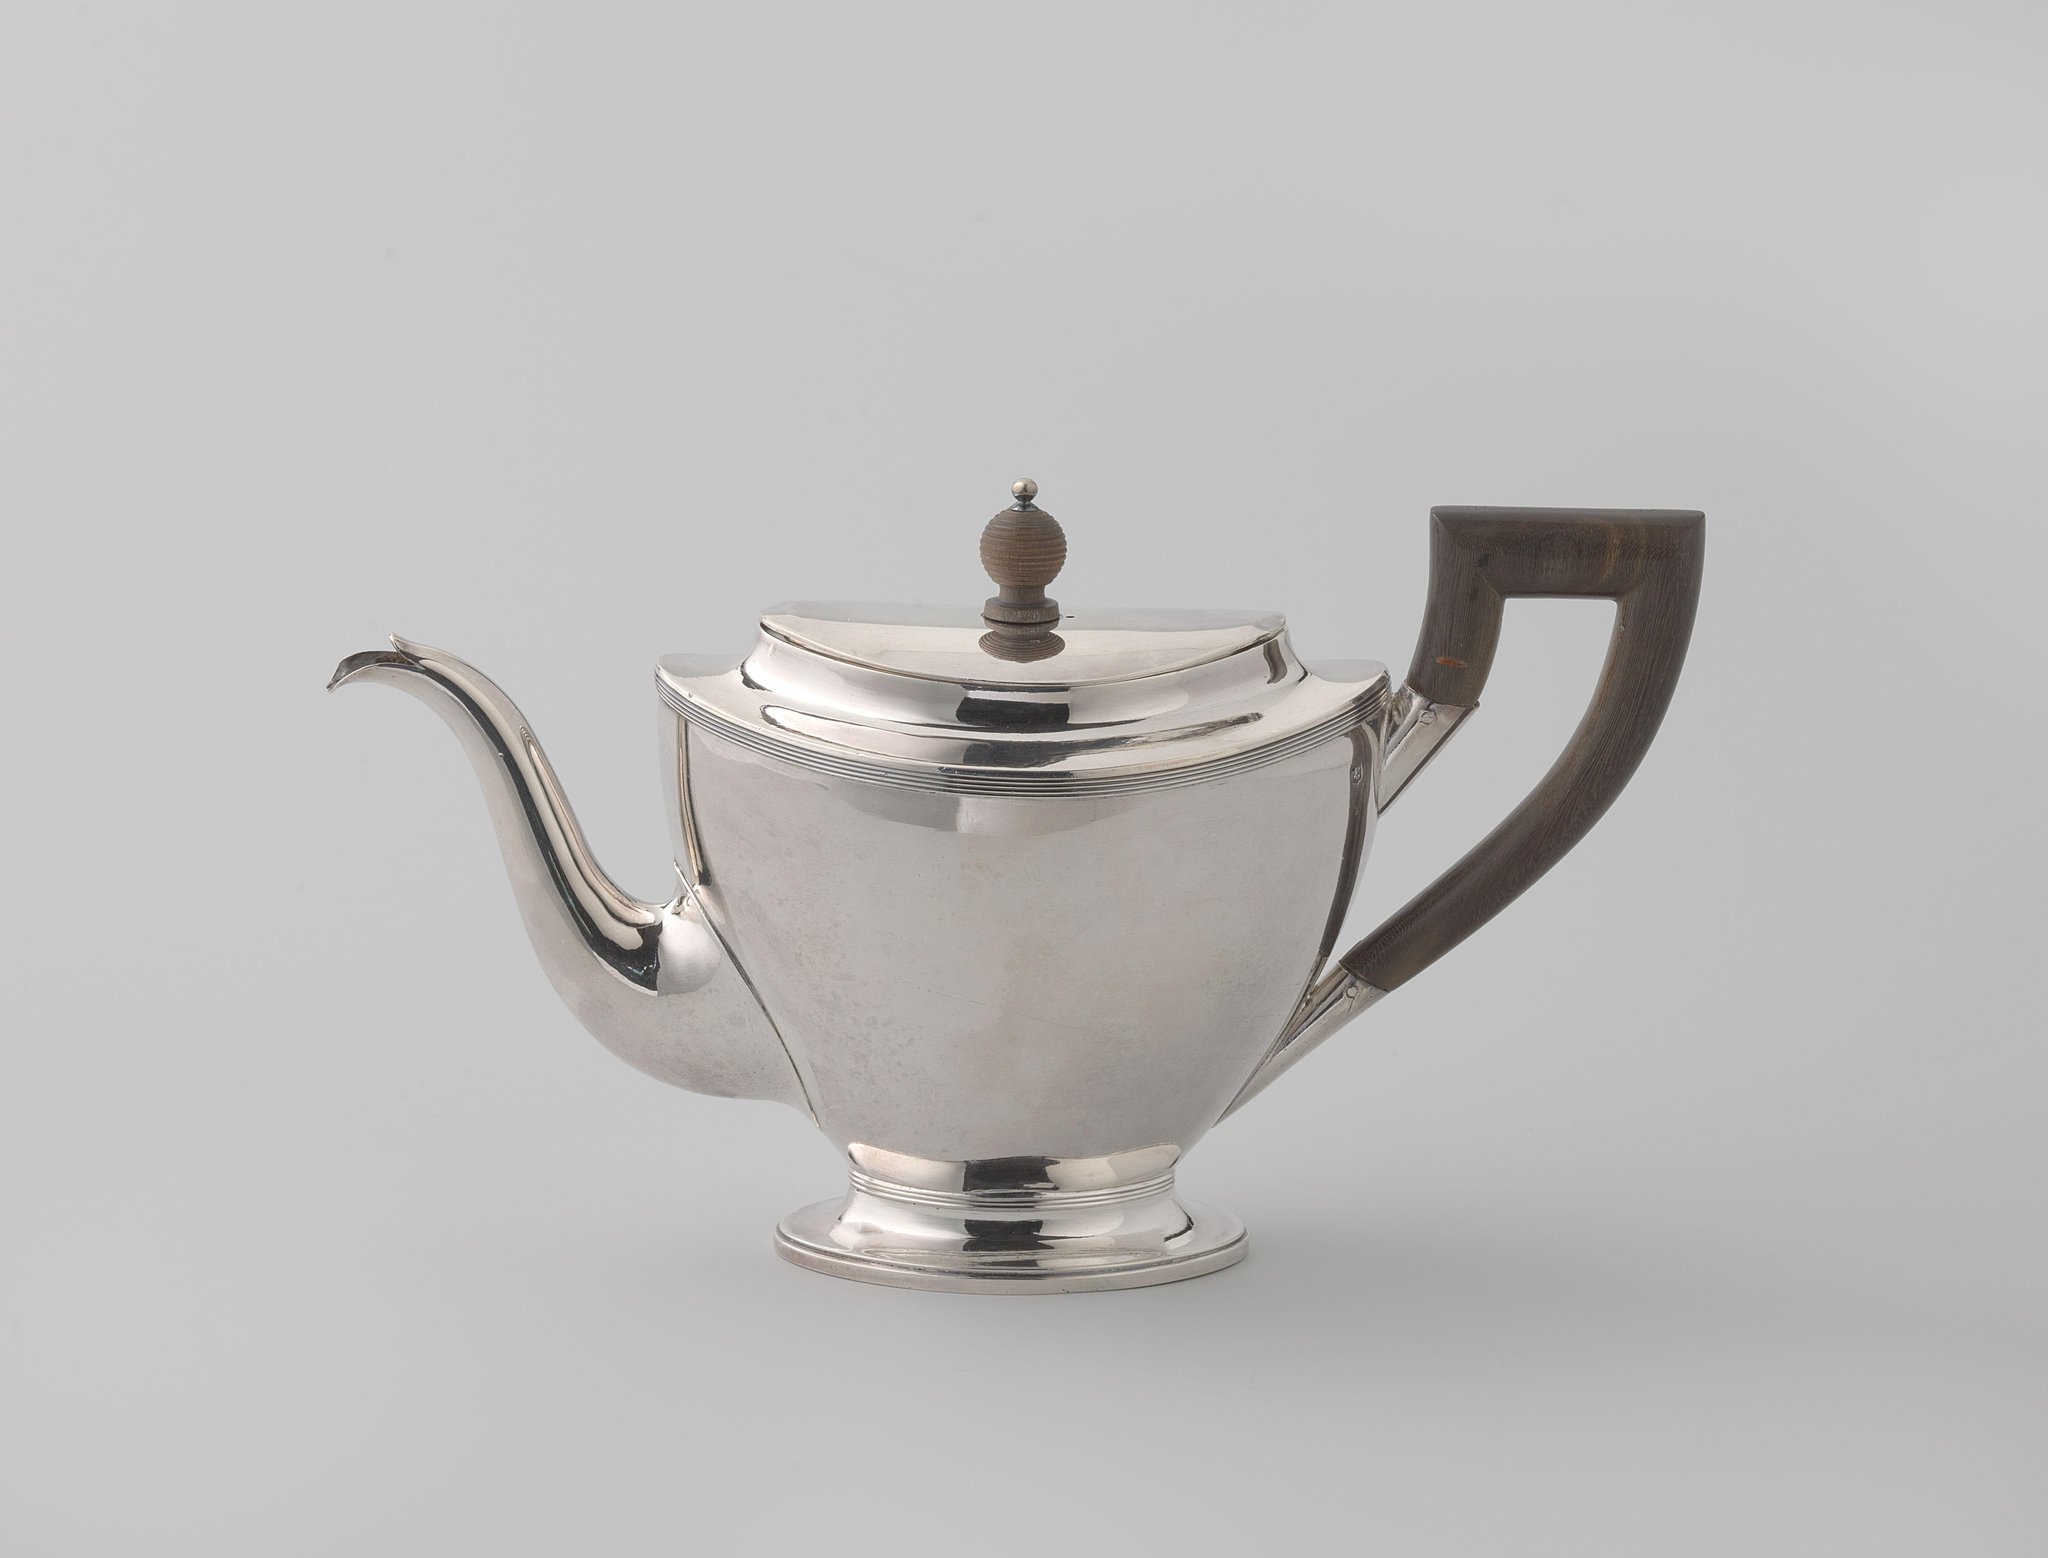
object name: teapot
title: Theepot, ovaal, met filetranden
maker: theodorus gerardus bentvelt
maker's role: silversmith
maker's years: 1782-1853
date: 1819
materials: wood, silver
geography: amsterdam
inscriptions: maker's mark, alloy mark, date letter: ‘K’, assayer's mark: ‘S1 in ovaal’, assay office mark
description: De ovale theepot rust op een gewelfde voet op een lage basis. Het gewelfde, zich verbredende lichaam en de gewelfde hals zijn beide aan de zijkanten iets verhoogd. Langs de bovenzijde van de voet en langs die van het lichaam lopen filetranden. De pot heeft een S-vormig gebogen tuit en een hoog ebbenhouten oor, dat aan de bovenzijde twee rechte hoeken vertoont en zilveren vattingen heeft. Het gladde deksel heeft een geribde bolvormige ebbenhouten knop, bekroond door een bolletje.